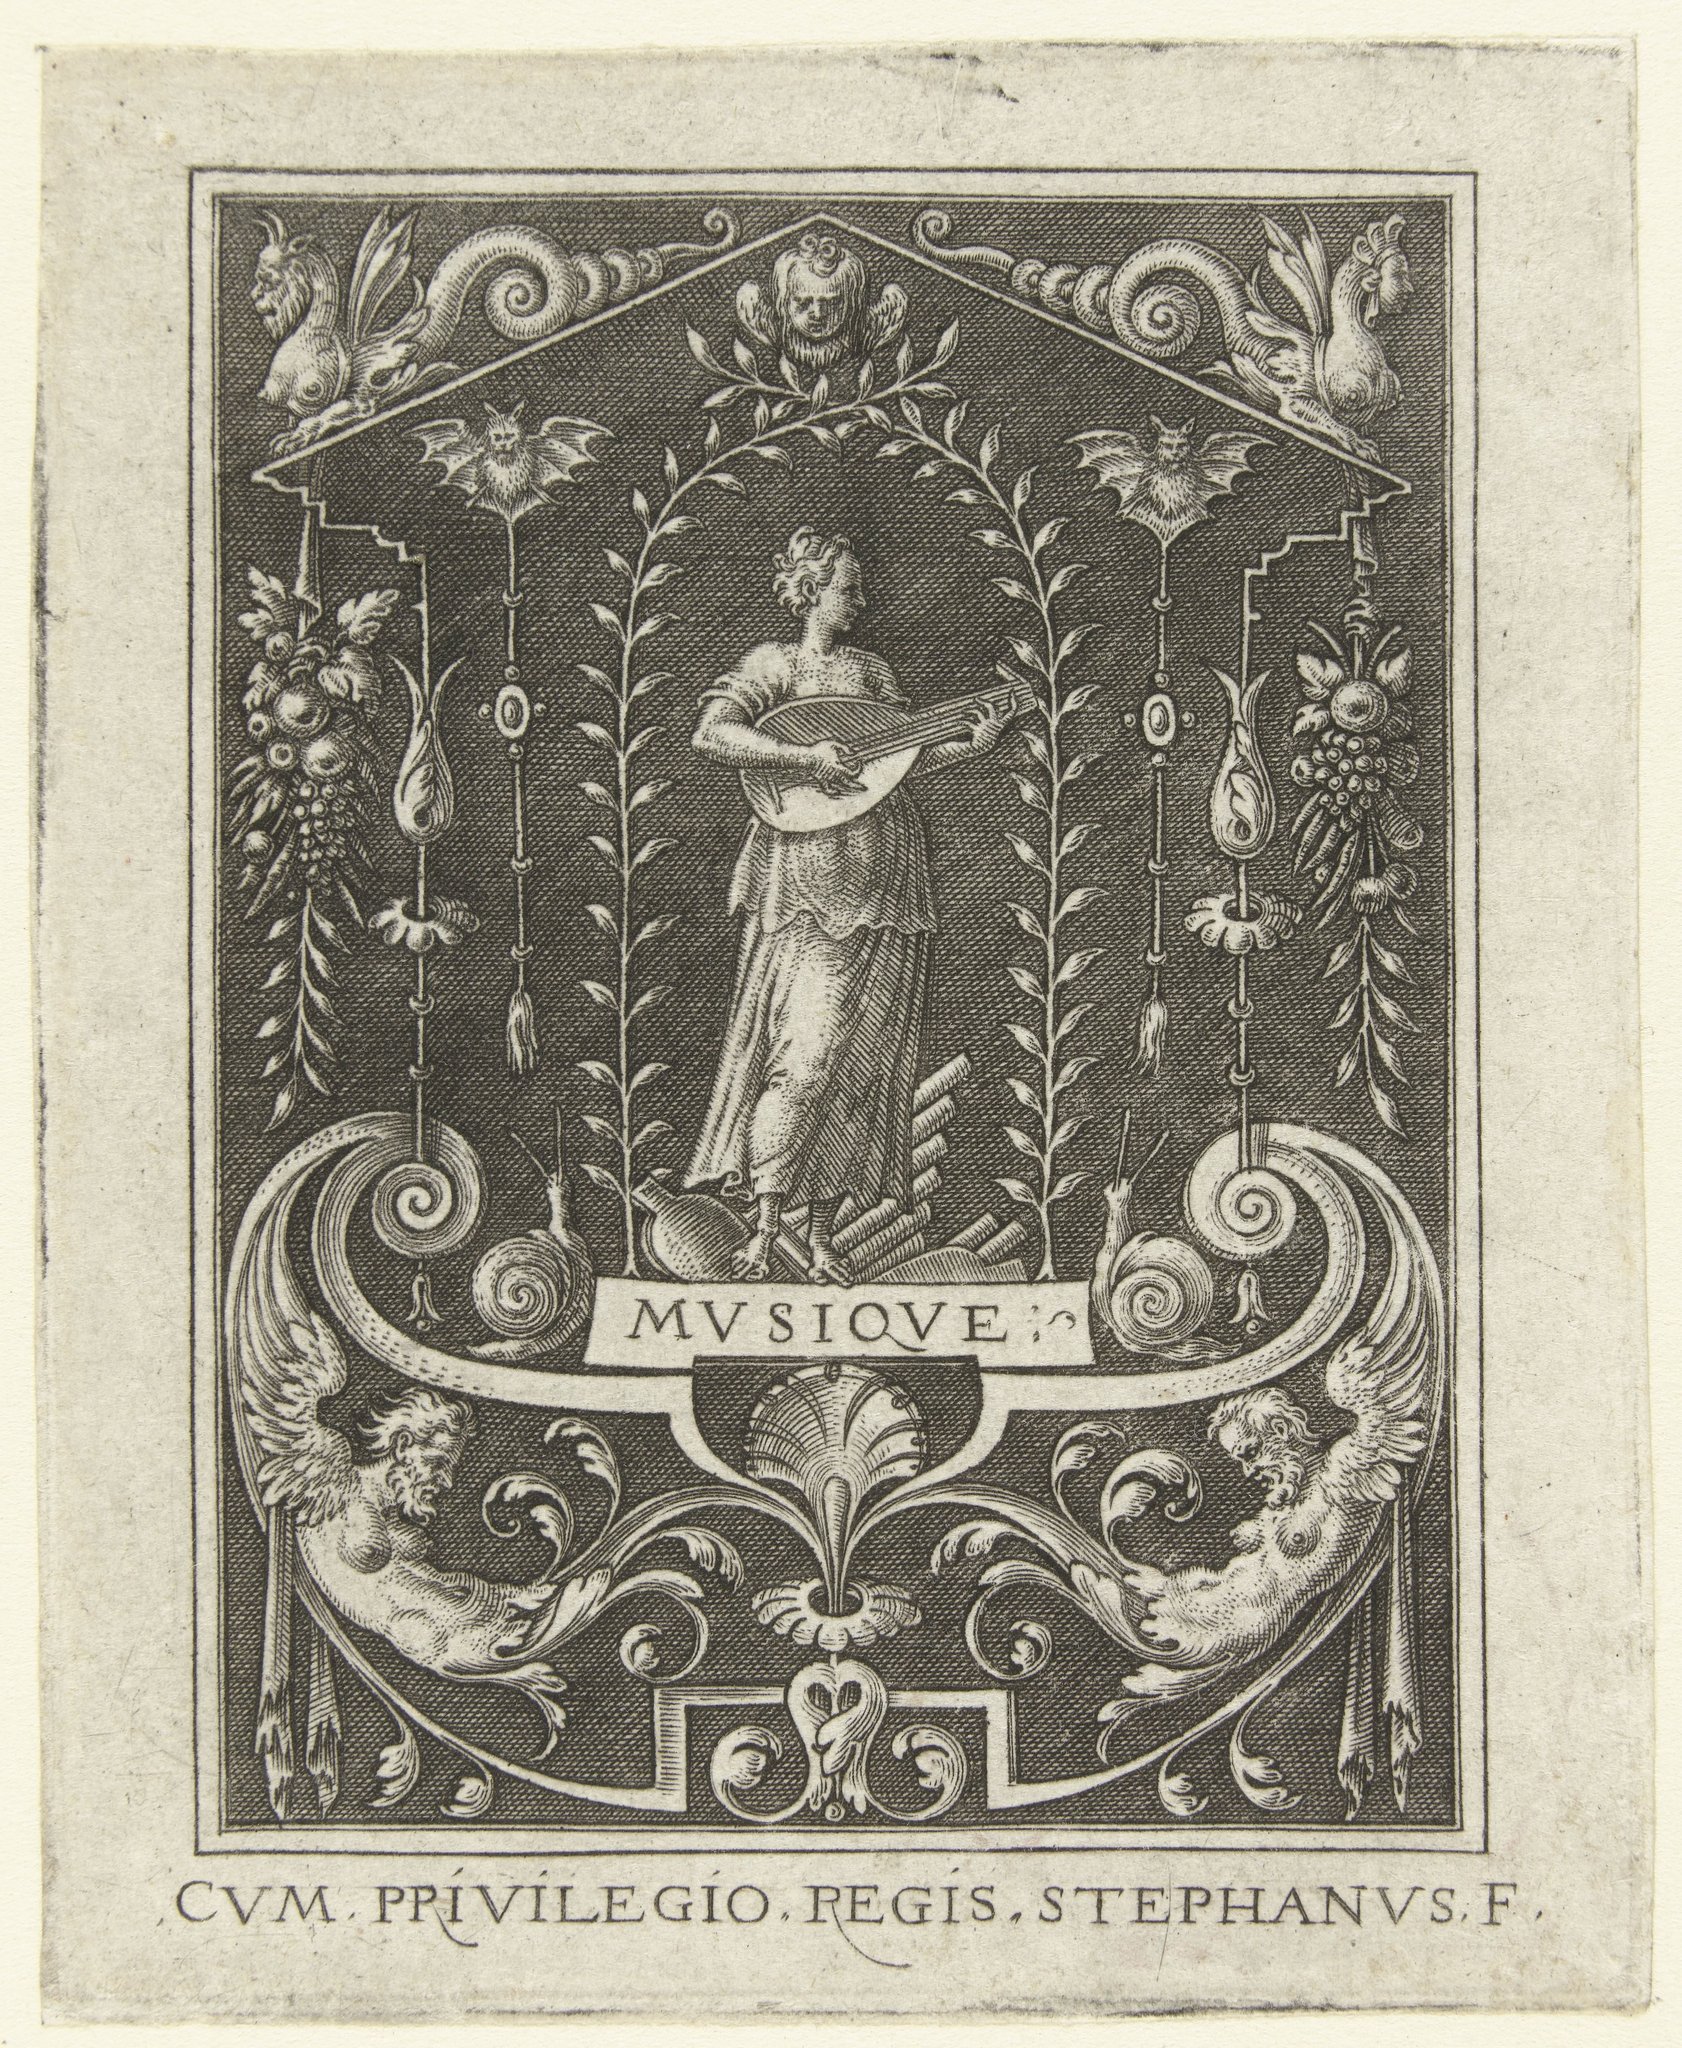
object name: ornament print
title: MVSIQVE:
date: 1528-1583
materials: paper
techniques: engraving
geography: france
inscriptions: collector's mark: Lugt 240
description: De Muziek, spelend op een snaarinstrument, onder een boog van bladeren. Uit serie van 6 bladen.